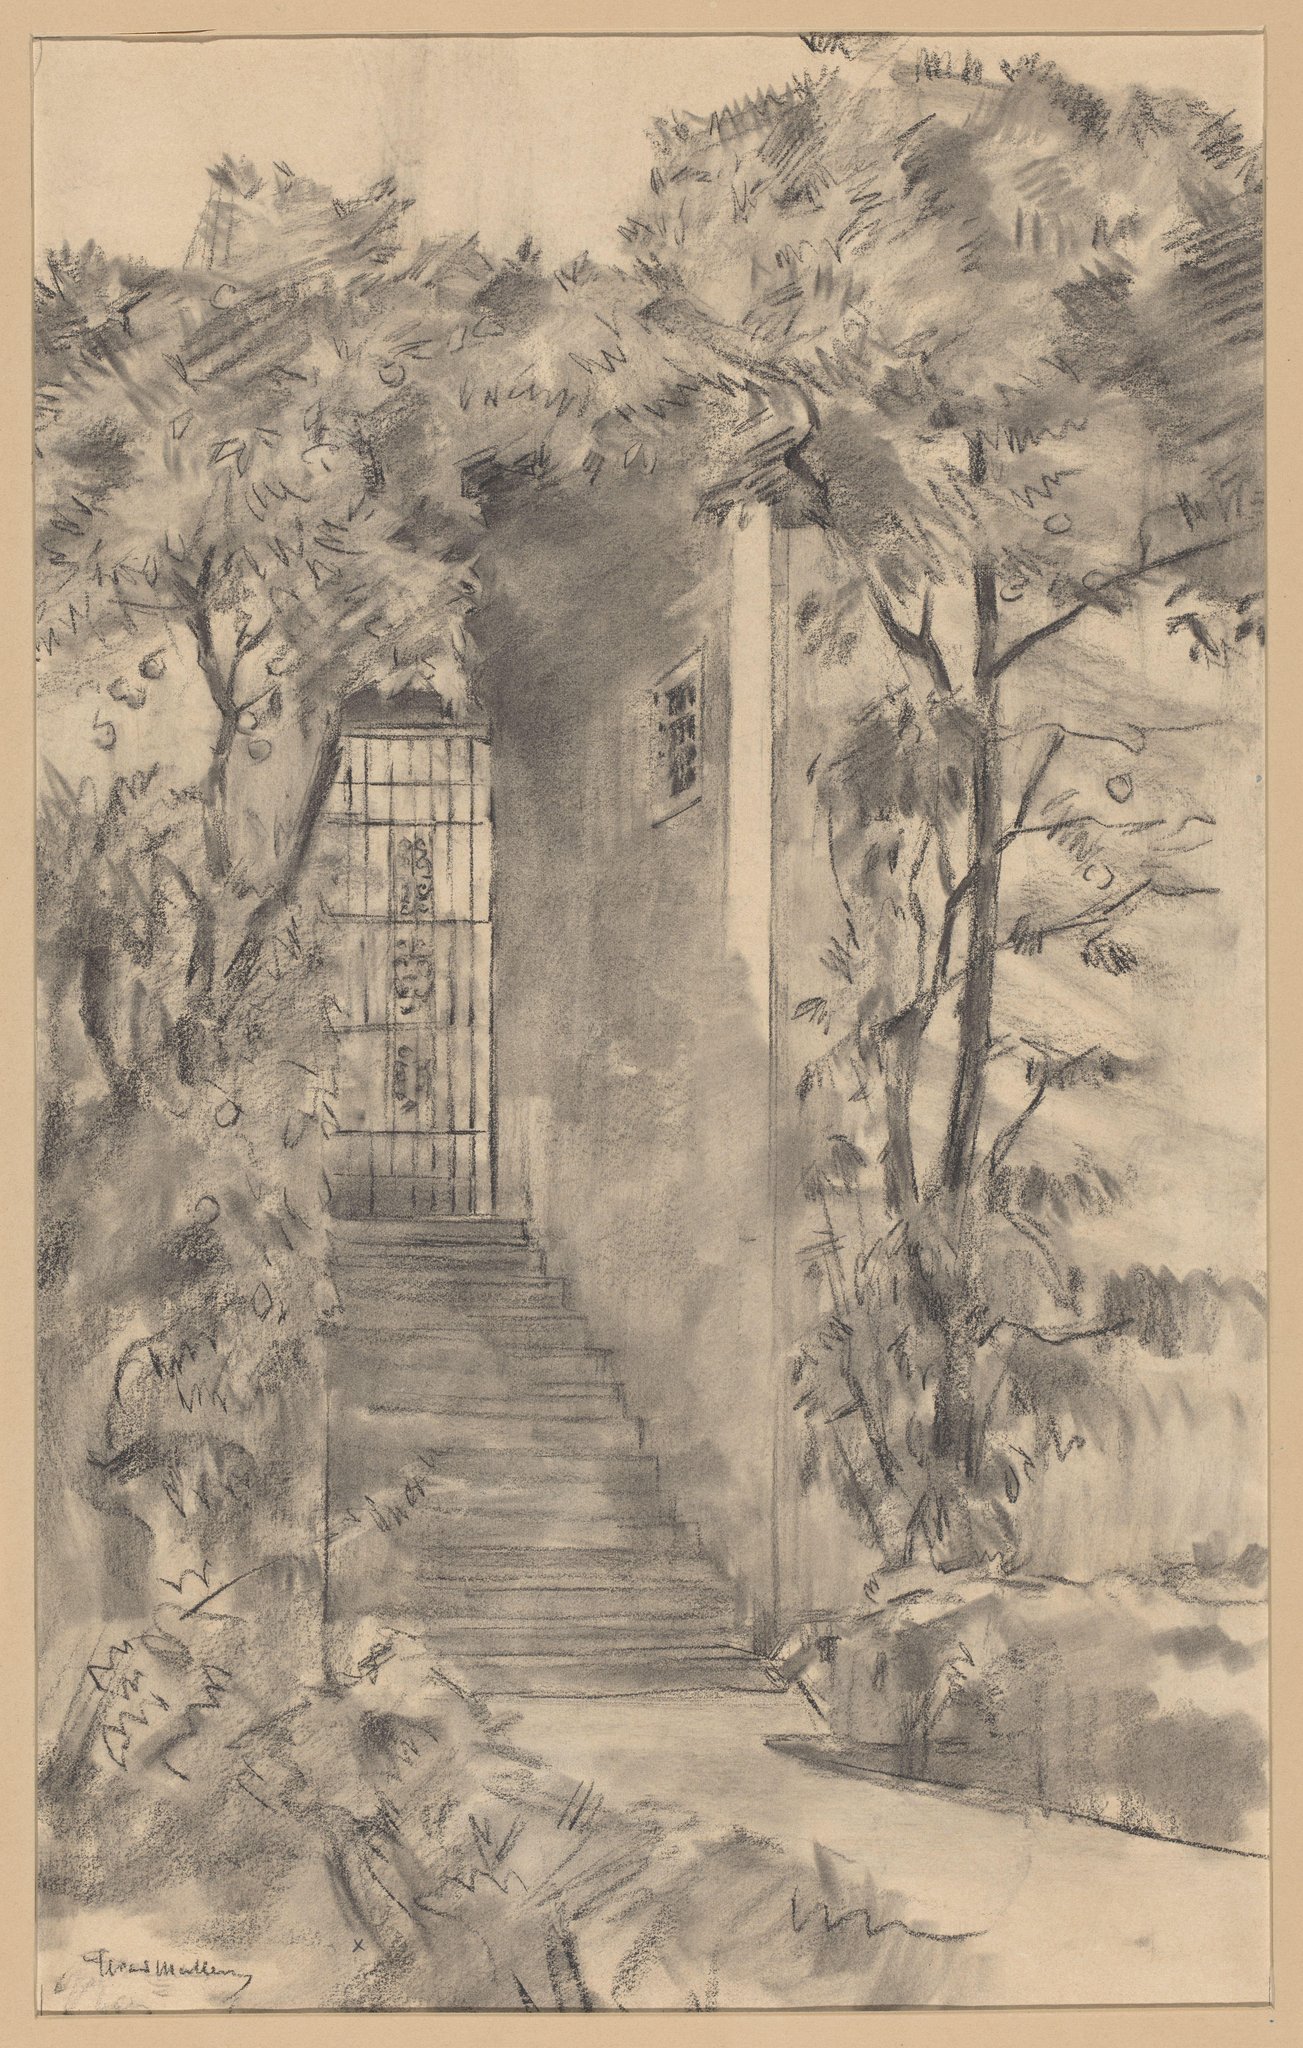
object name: drawing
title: Doorgang tussen de tuinen van het Koninklijk Paleis te Sevilla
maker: gerard muller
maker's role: draughtsman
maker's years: 1861-1929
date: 1871-1903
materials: chalk, paper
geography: sevilla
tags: garden, palace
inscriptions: collector's mark: Lugt 2228, label: ‘11. Alcázar . Sevilla/ Doorgang tusschen de tuinen.’